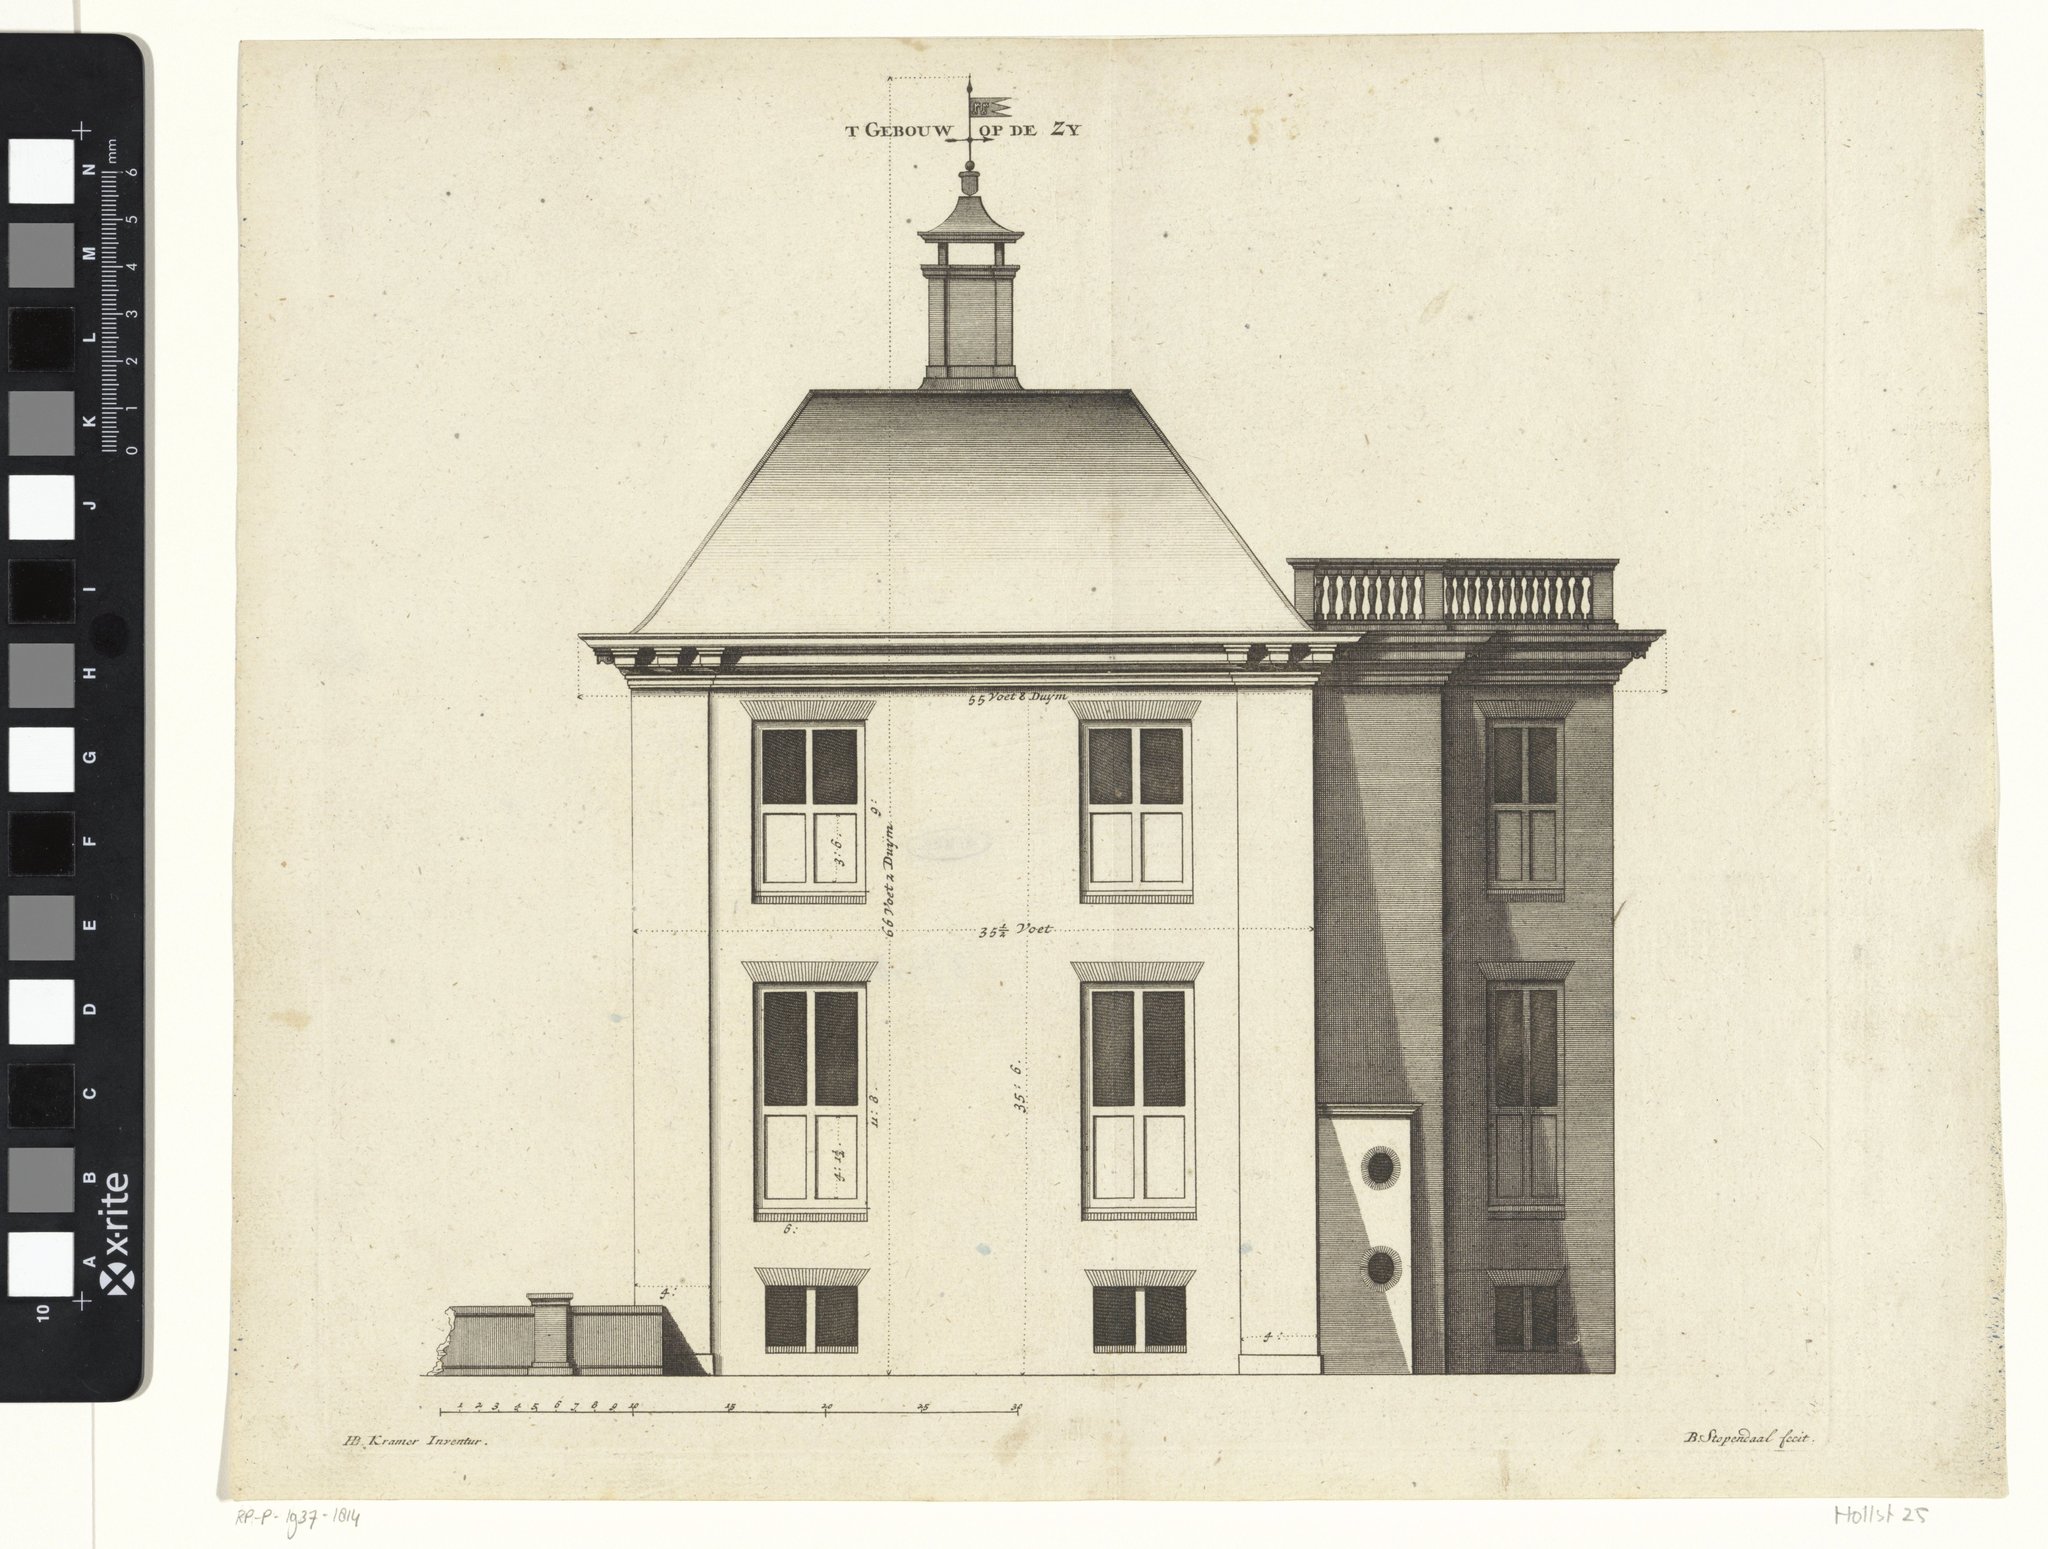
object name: print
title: T Gebouw op de zy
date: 1687-1693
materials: paper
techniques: etching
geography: amsterdam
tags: exterior ~ representation of a building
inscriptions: collector's mark: Lugt 2228, collector's mark: Lugt 2760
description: Zijaanzicht van huis De Nes of Realeneiland te Vreeland. Het voor de Amsterdamse familie Reaal in 1687 gebouwde buitenhuis lag op een eiland in de Vecht.